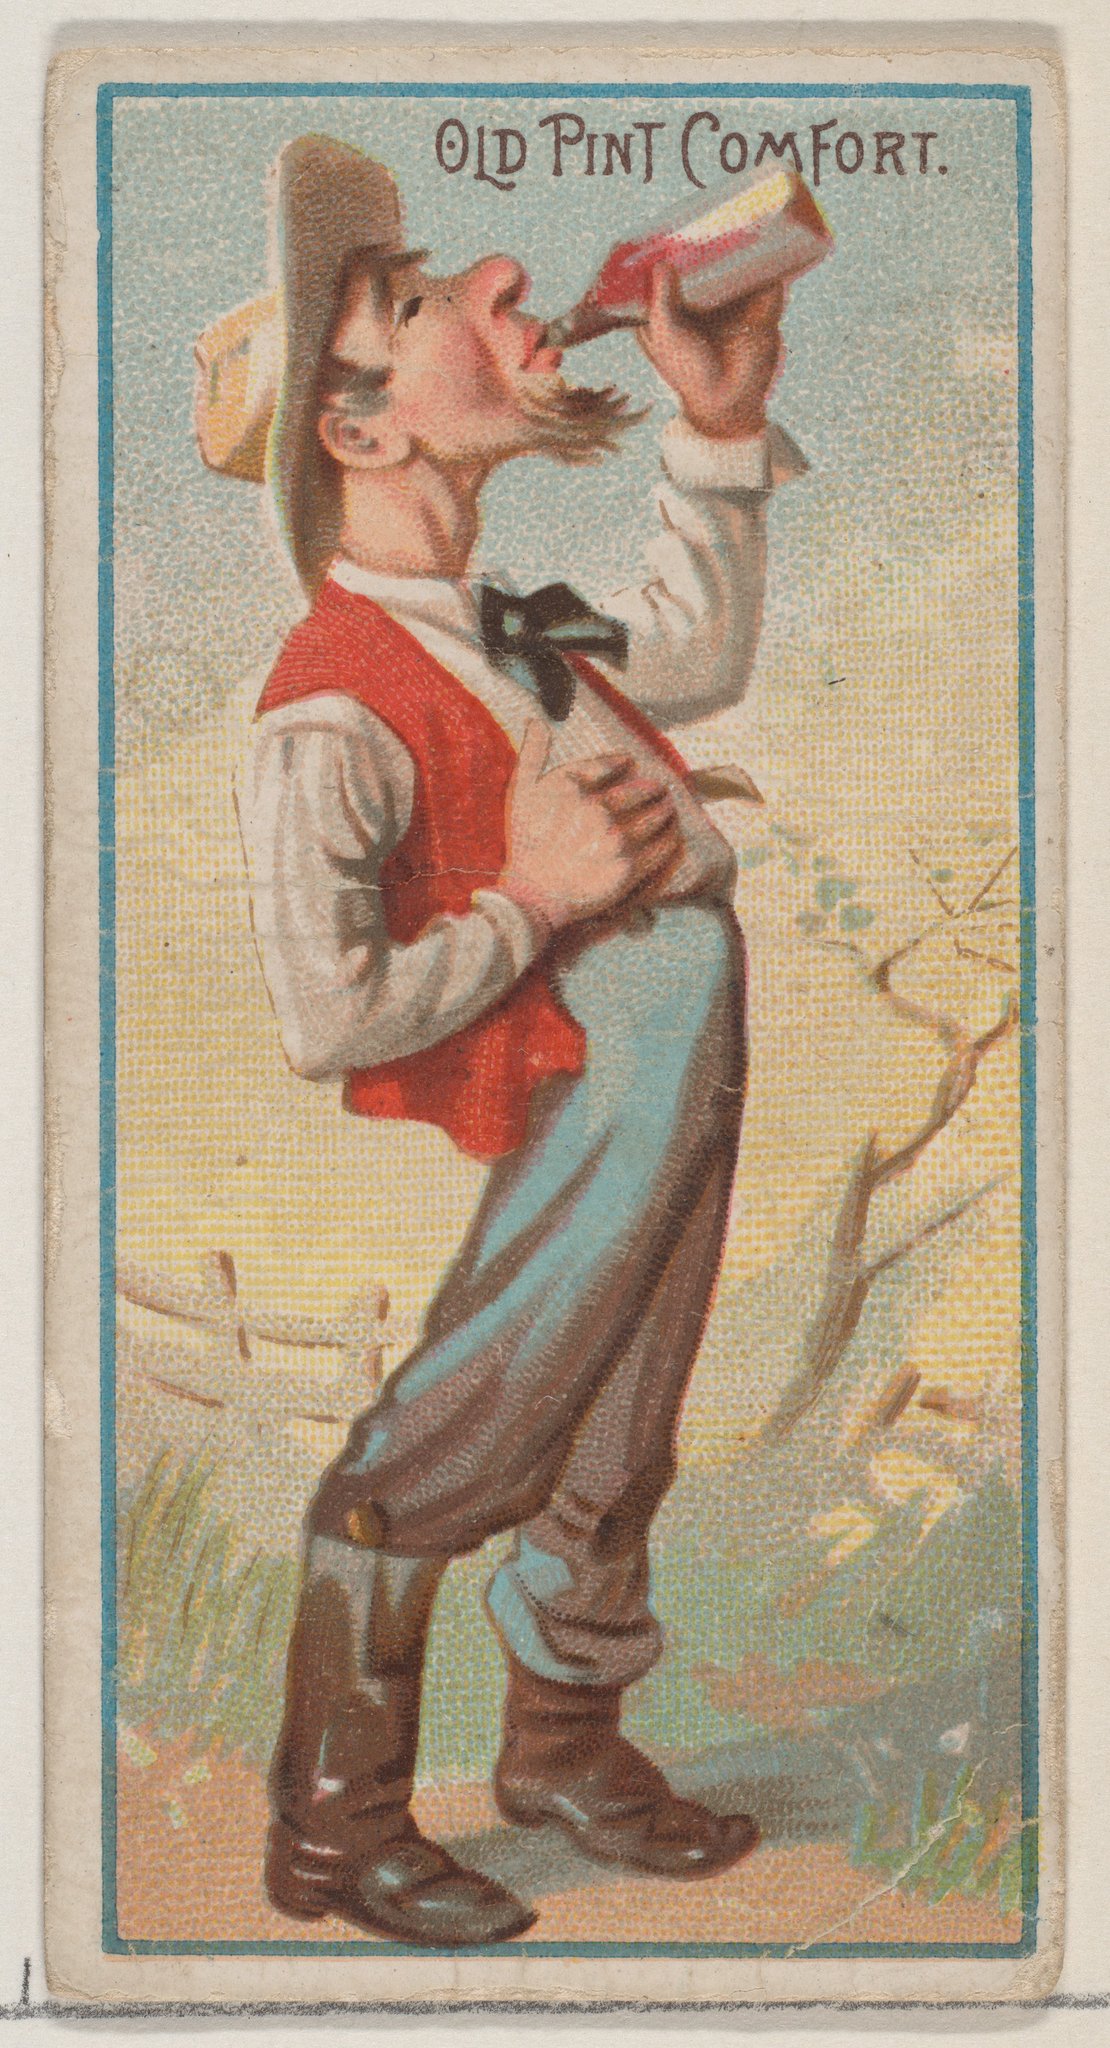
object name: print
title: Old Pint Comfort, from the Jokes series (N87) for Duke brand cigarettes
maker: w. duke, sons & co.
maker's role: publisher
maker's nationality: american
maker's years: 1870-1920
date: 1890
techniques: color lithograph